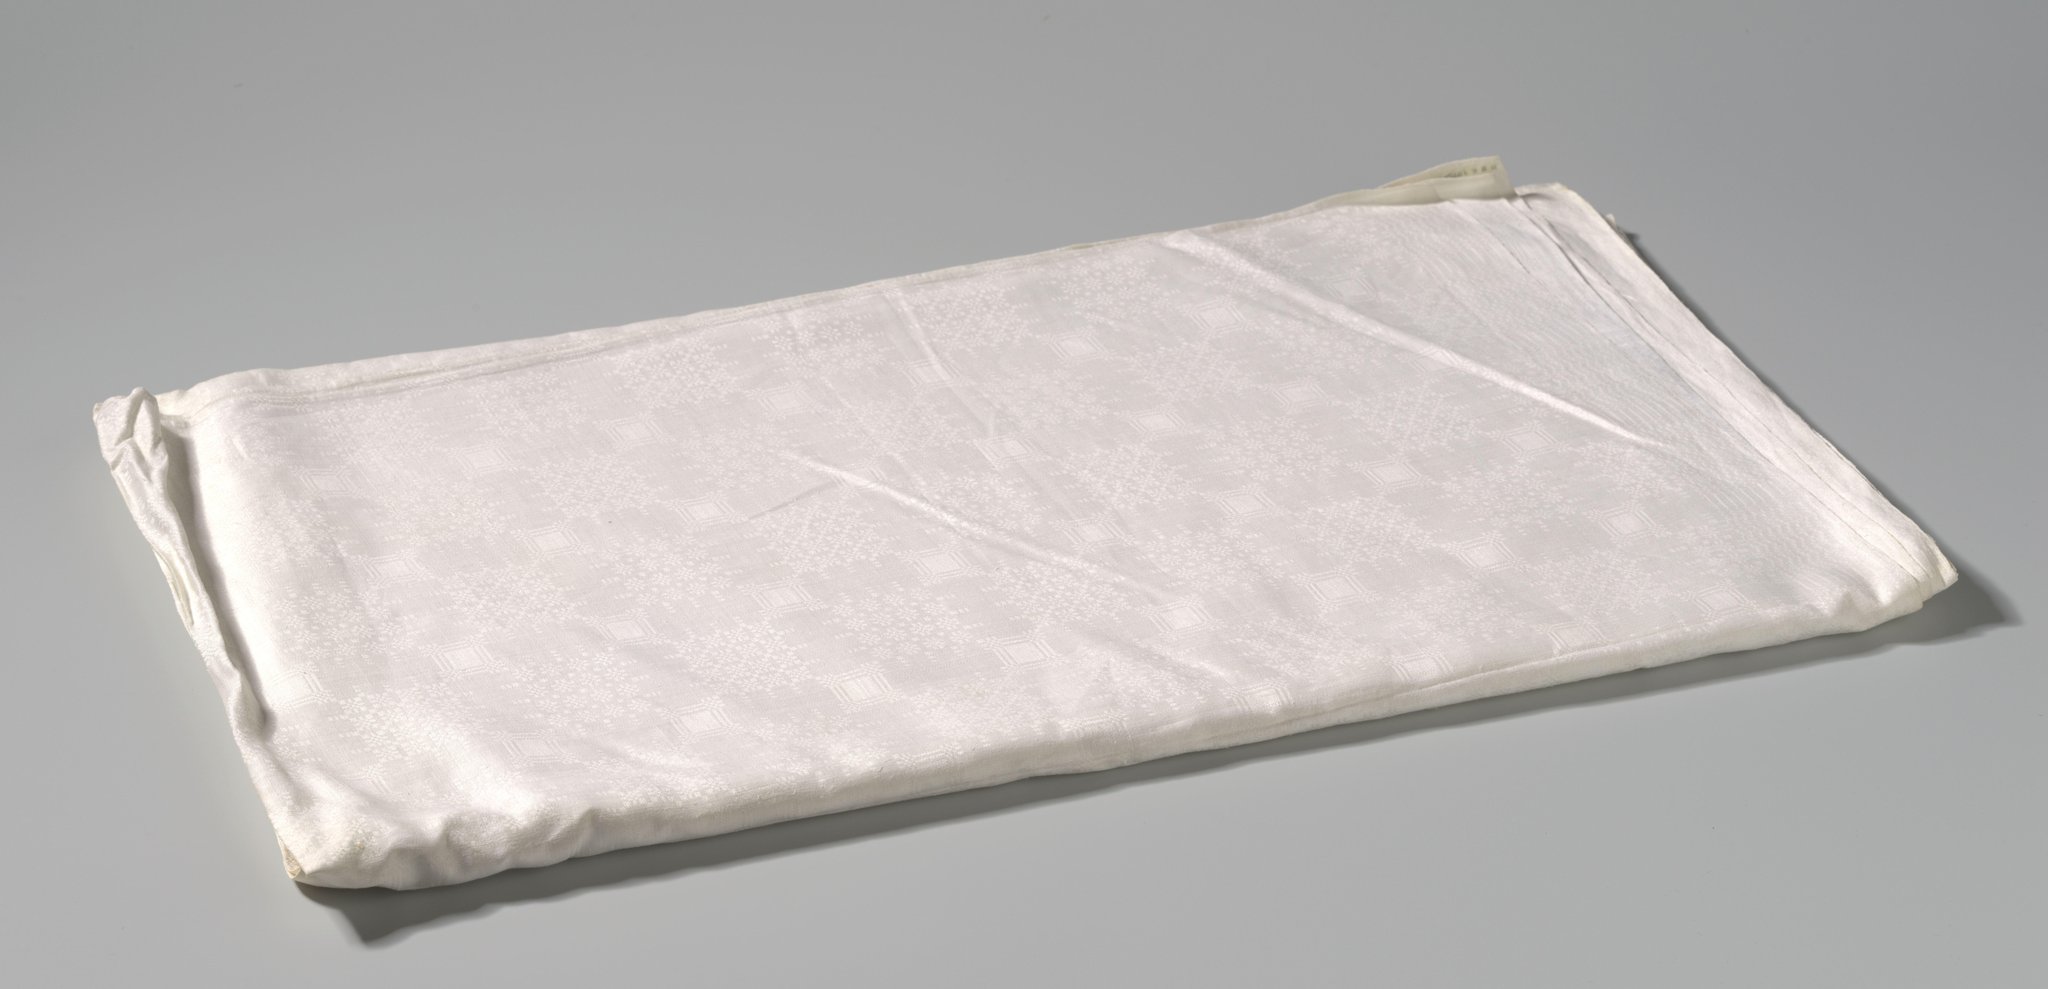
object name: tablecloth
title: Tafellaken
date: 1700-1800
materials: linen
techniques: peeled fabric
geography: netherlands